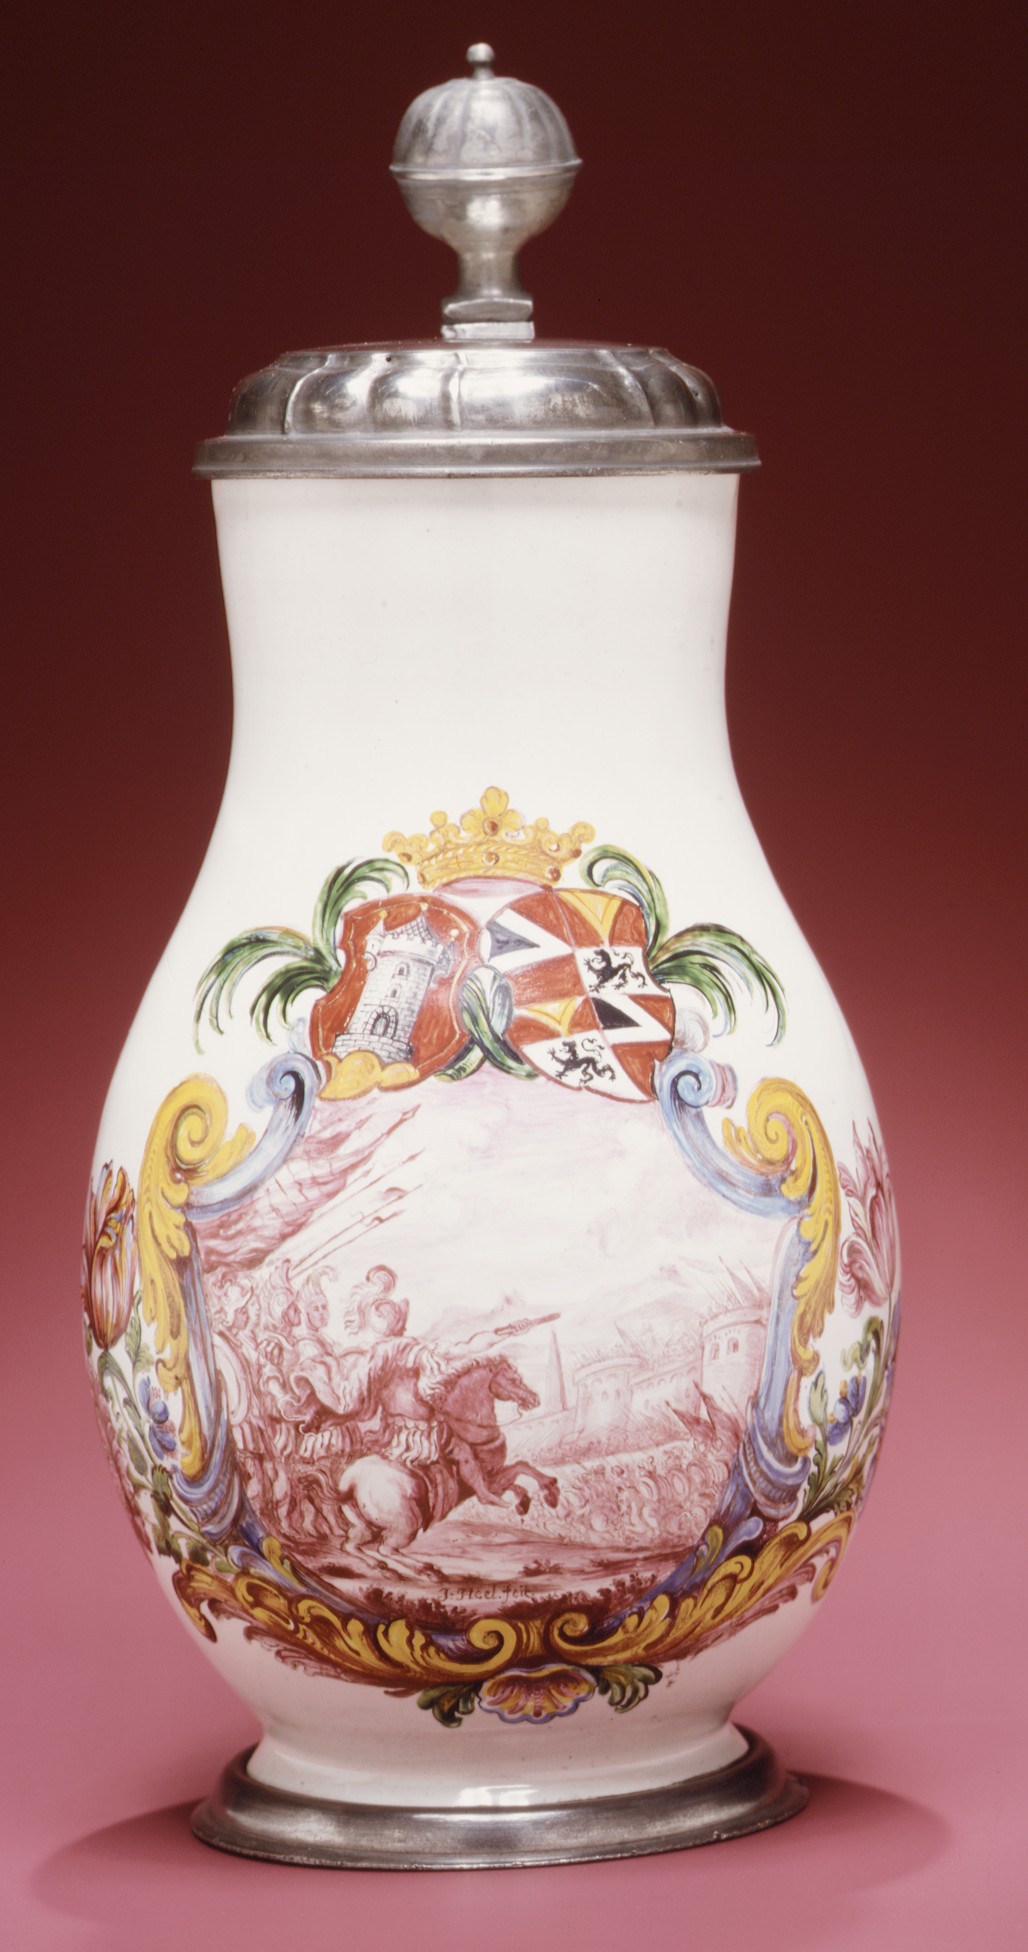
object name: jug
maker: johann heel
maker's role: decorator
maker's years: 1637-1709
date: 1680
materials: faience, pewter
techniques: glazing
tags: men,horses,coat of arms